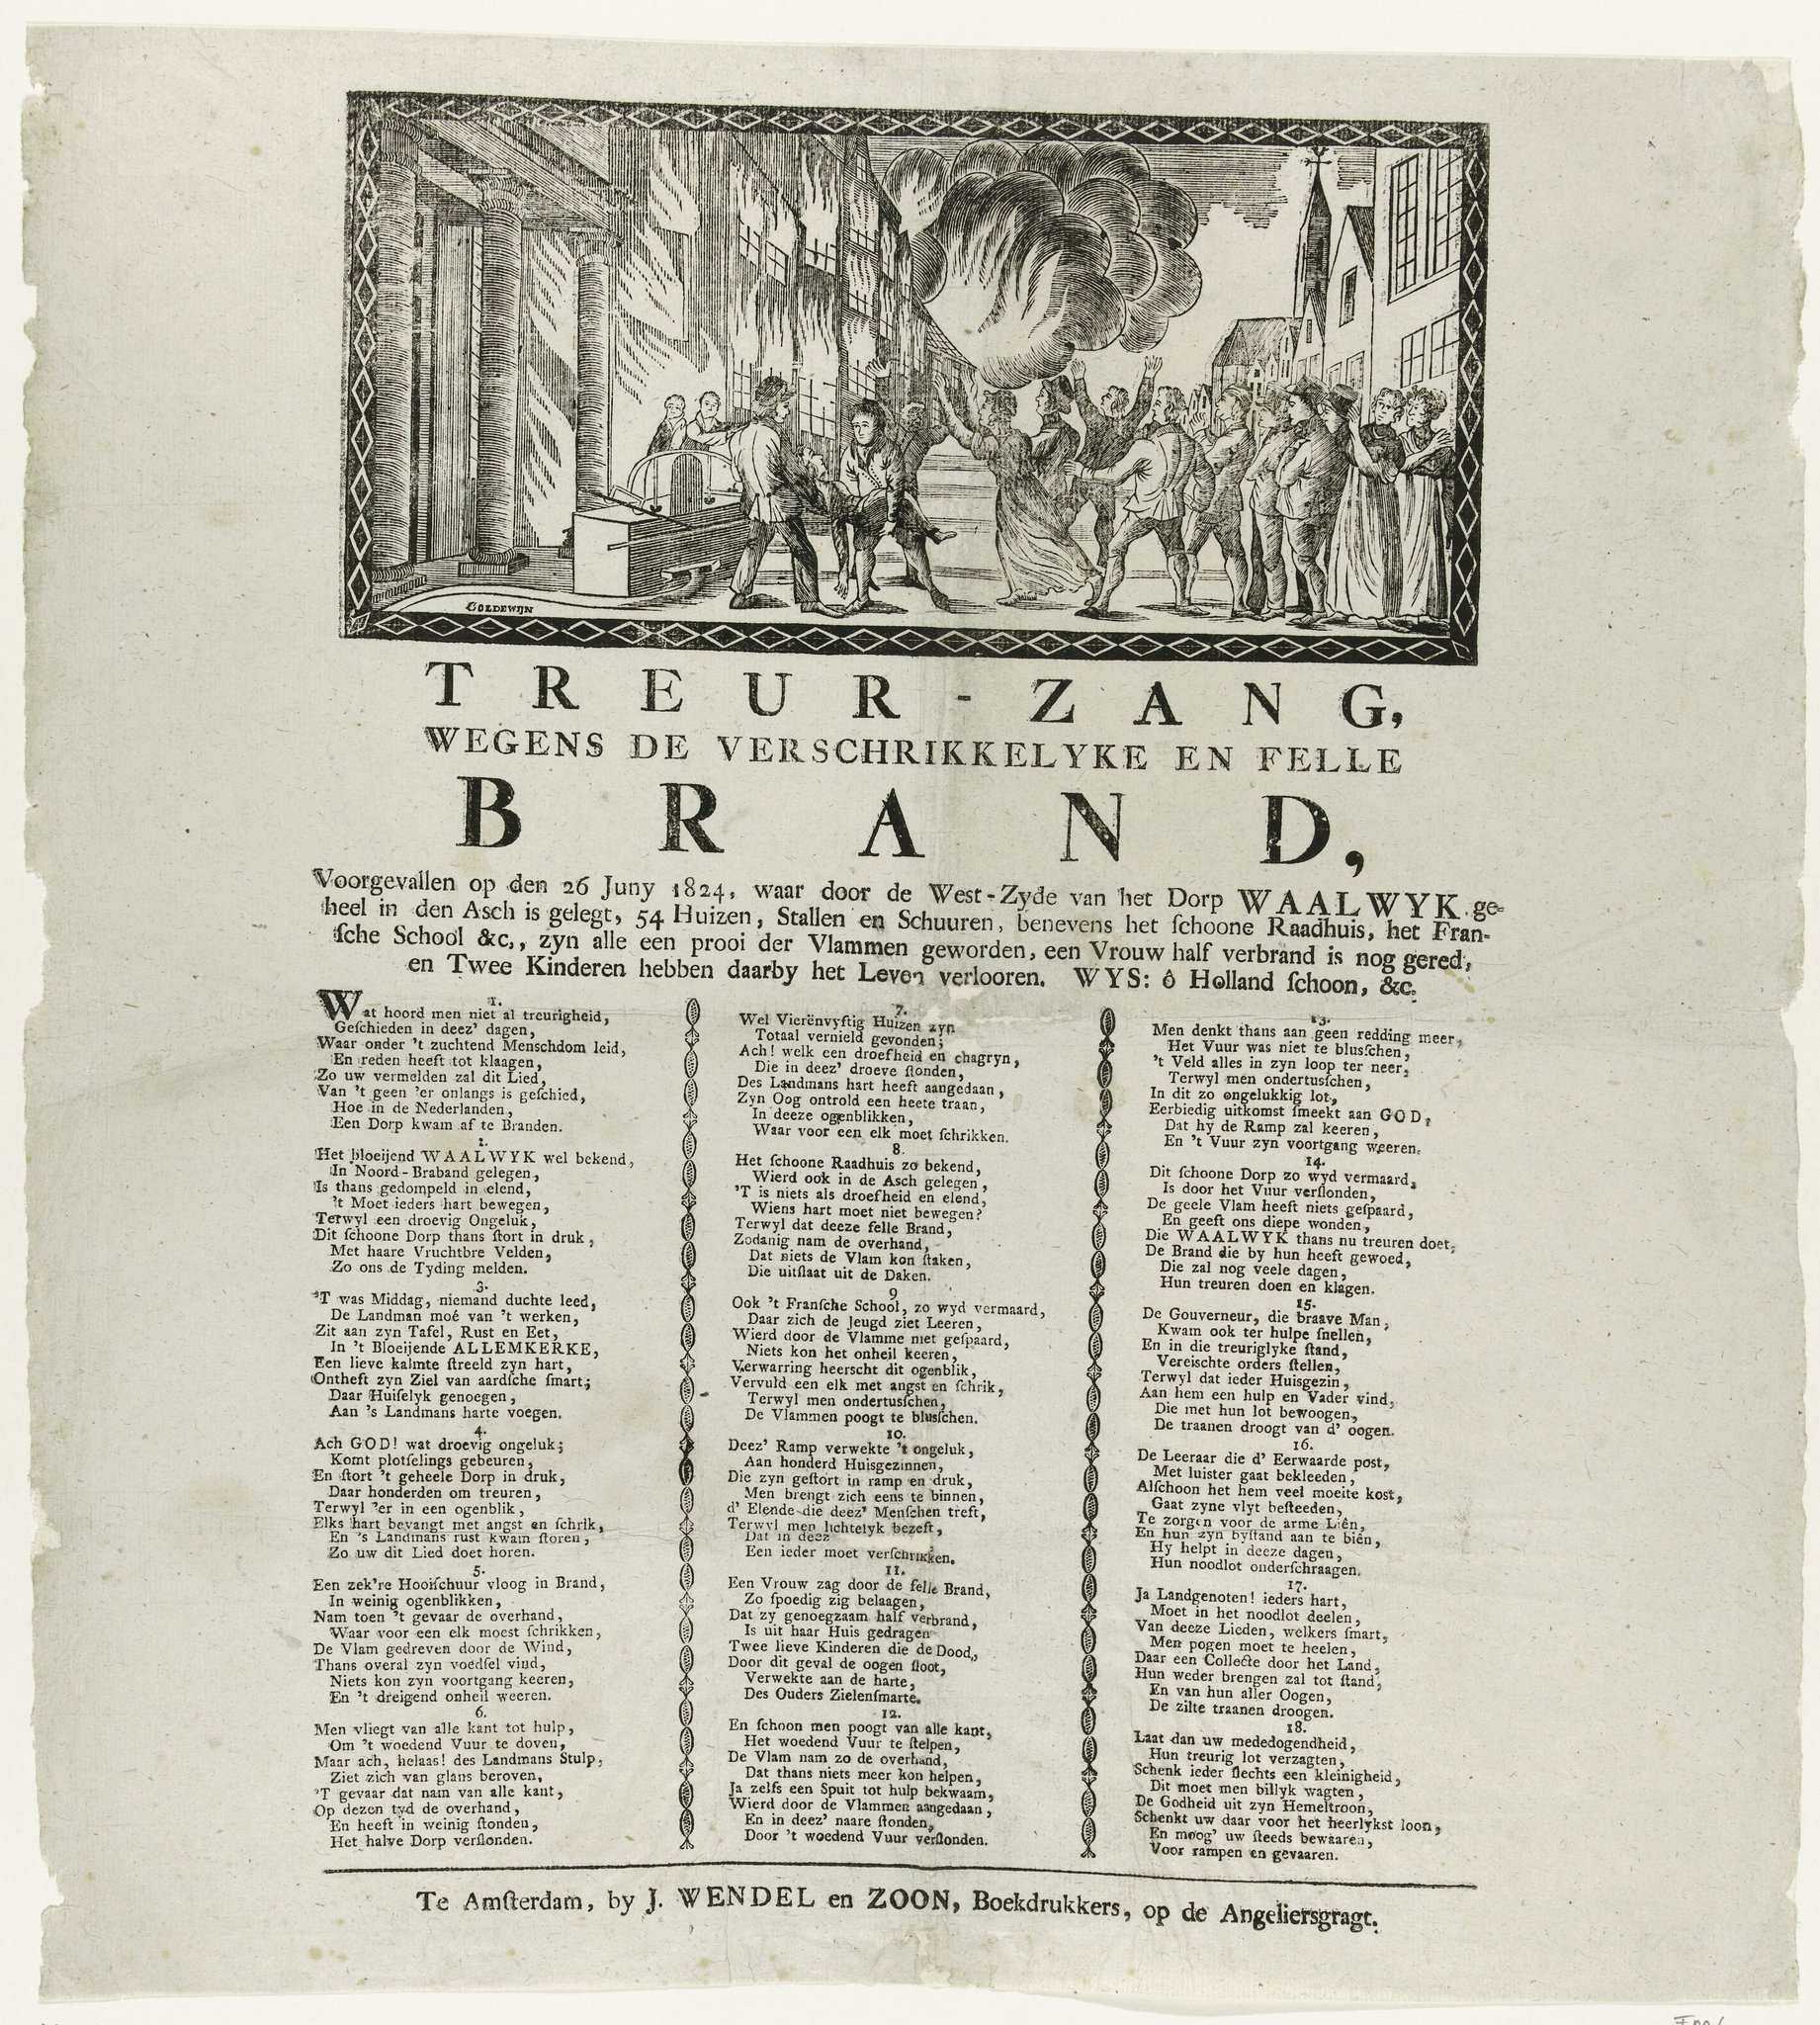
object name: print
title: Treur-zang, wegens de verschrikkelyke en felle Brand, Voorgevallen op den 26 Juny 1824, waar door de West-Zyde van het Dorp Waalwyk geheel in den Asch is gelegt (...)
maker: jacob coldewijn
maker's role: print maker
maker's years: 1796-1855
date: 1824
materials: paper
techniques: letterpress printing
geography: netherlands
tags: on fire, ablaze, waalwijk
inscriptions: collector's mark: Lugt 2228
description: Treurzang op de brand in het dorp Waalwijk op 26 juni 1824. Lied in achttien coupletten. Bovenaan een voorstelling van de brand waarbij een vrouw uit de vlammen wordt gered. Bij de brand werden 54 huizen, het Raadhuis en de Franse school verwoest en verloren twee kinderen het leven.